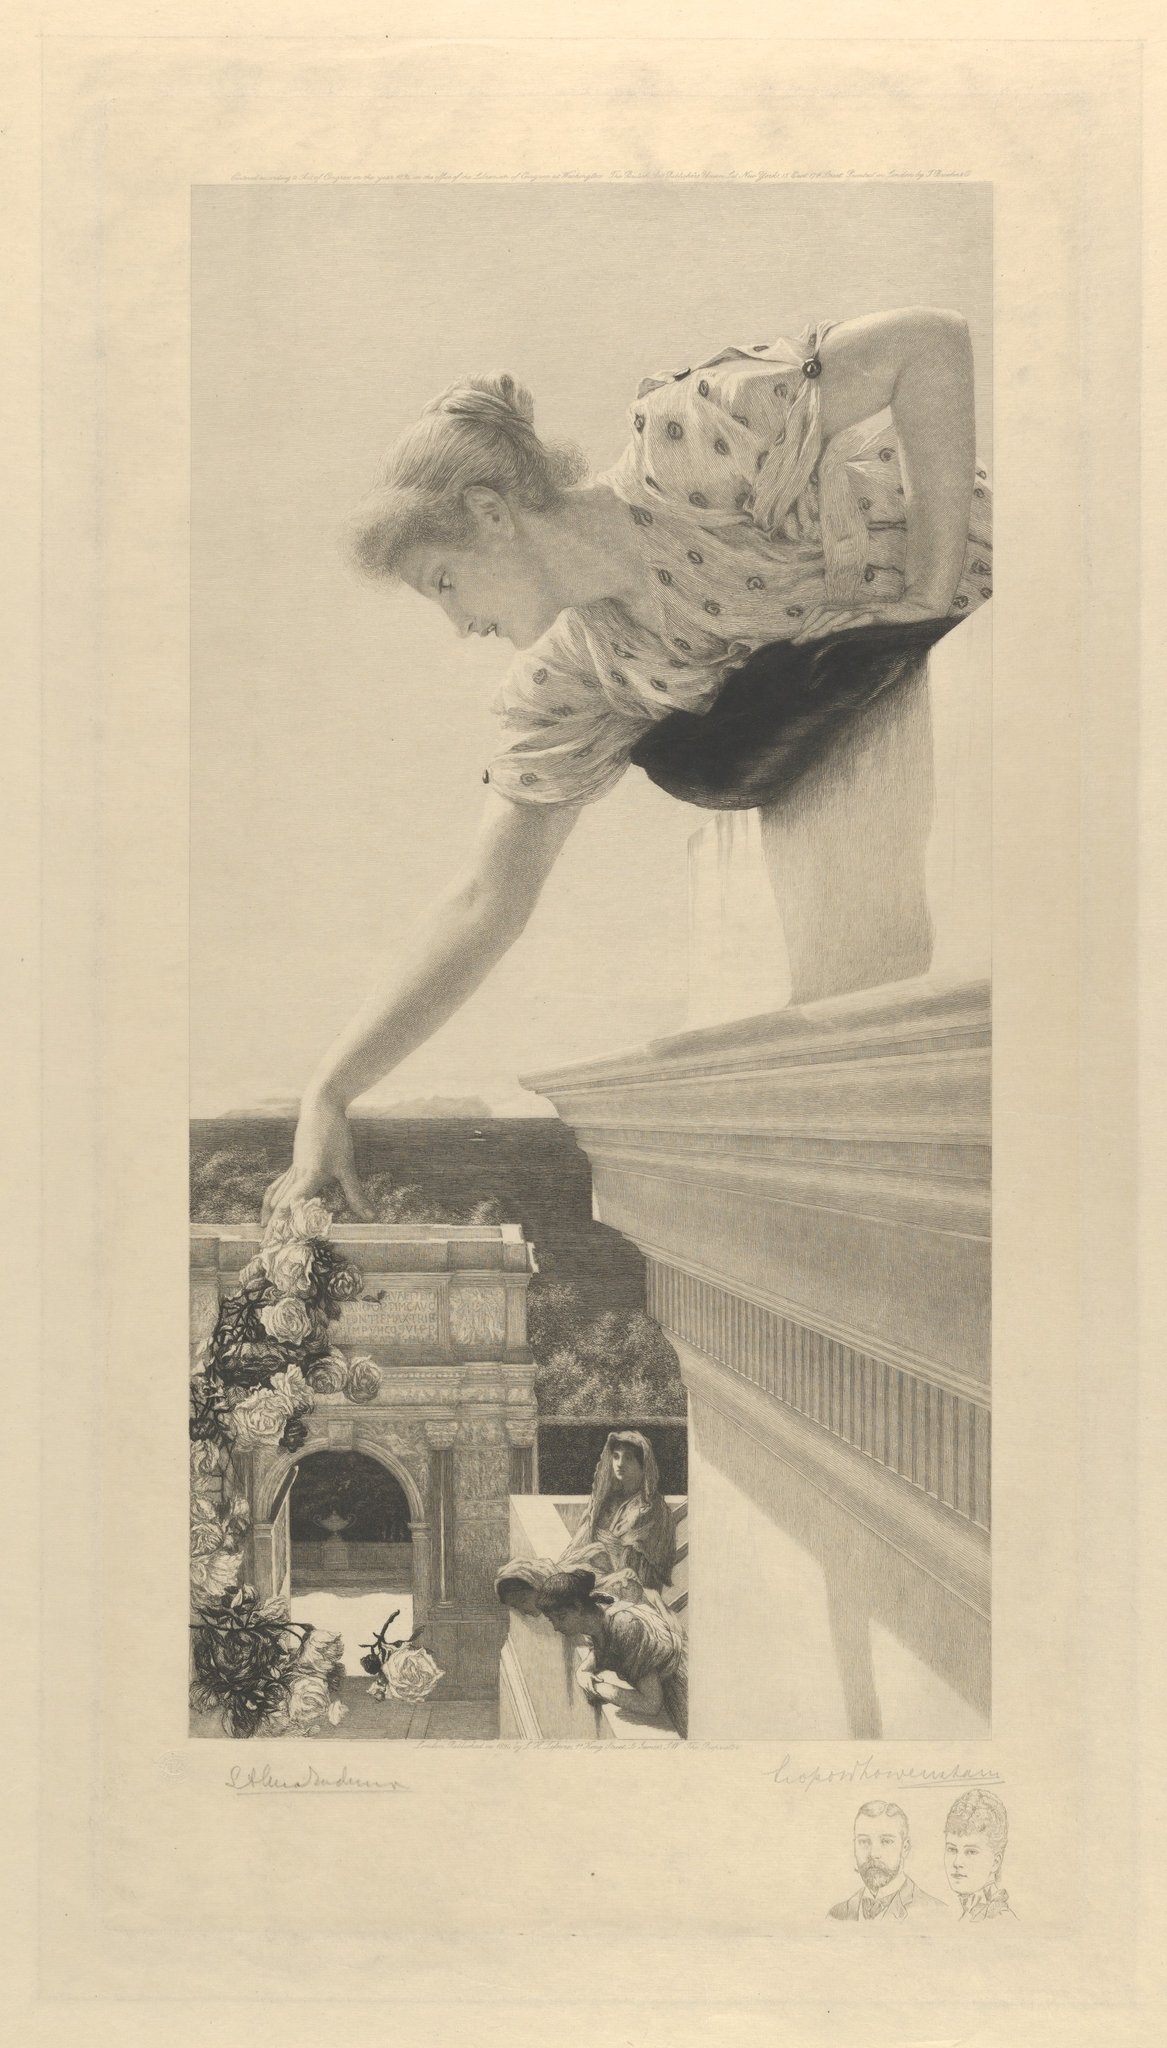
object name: print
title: God Speed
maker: sir lawrence alma-tadema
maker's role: artist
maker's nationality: british, born the netherlands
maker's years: 1836-1912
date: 1894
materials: paper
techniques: etching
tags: profiles,women,roses,rome